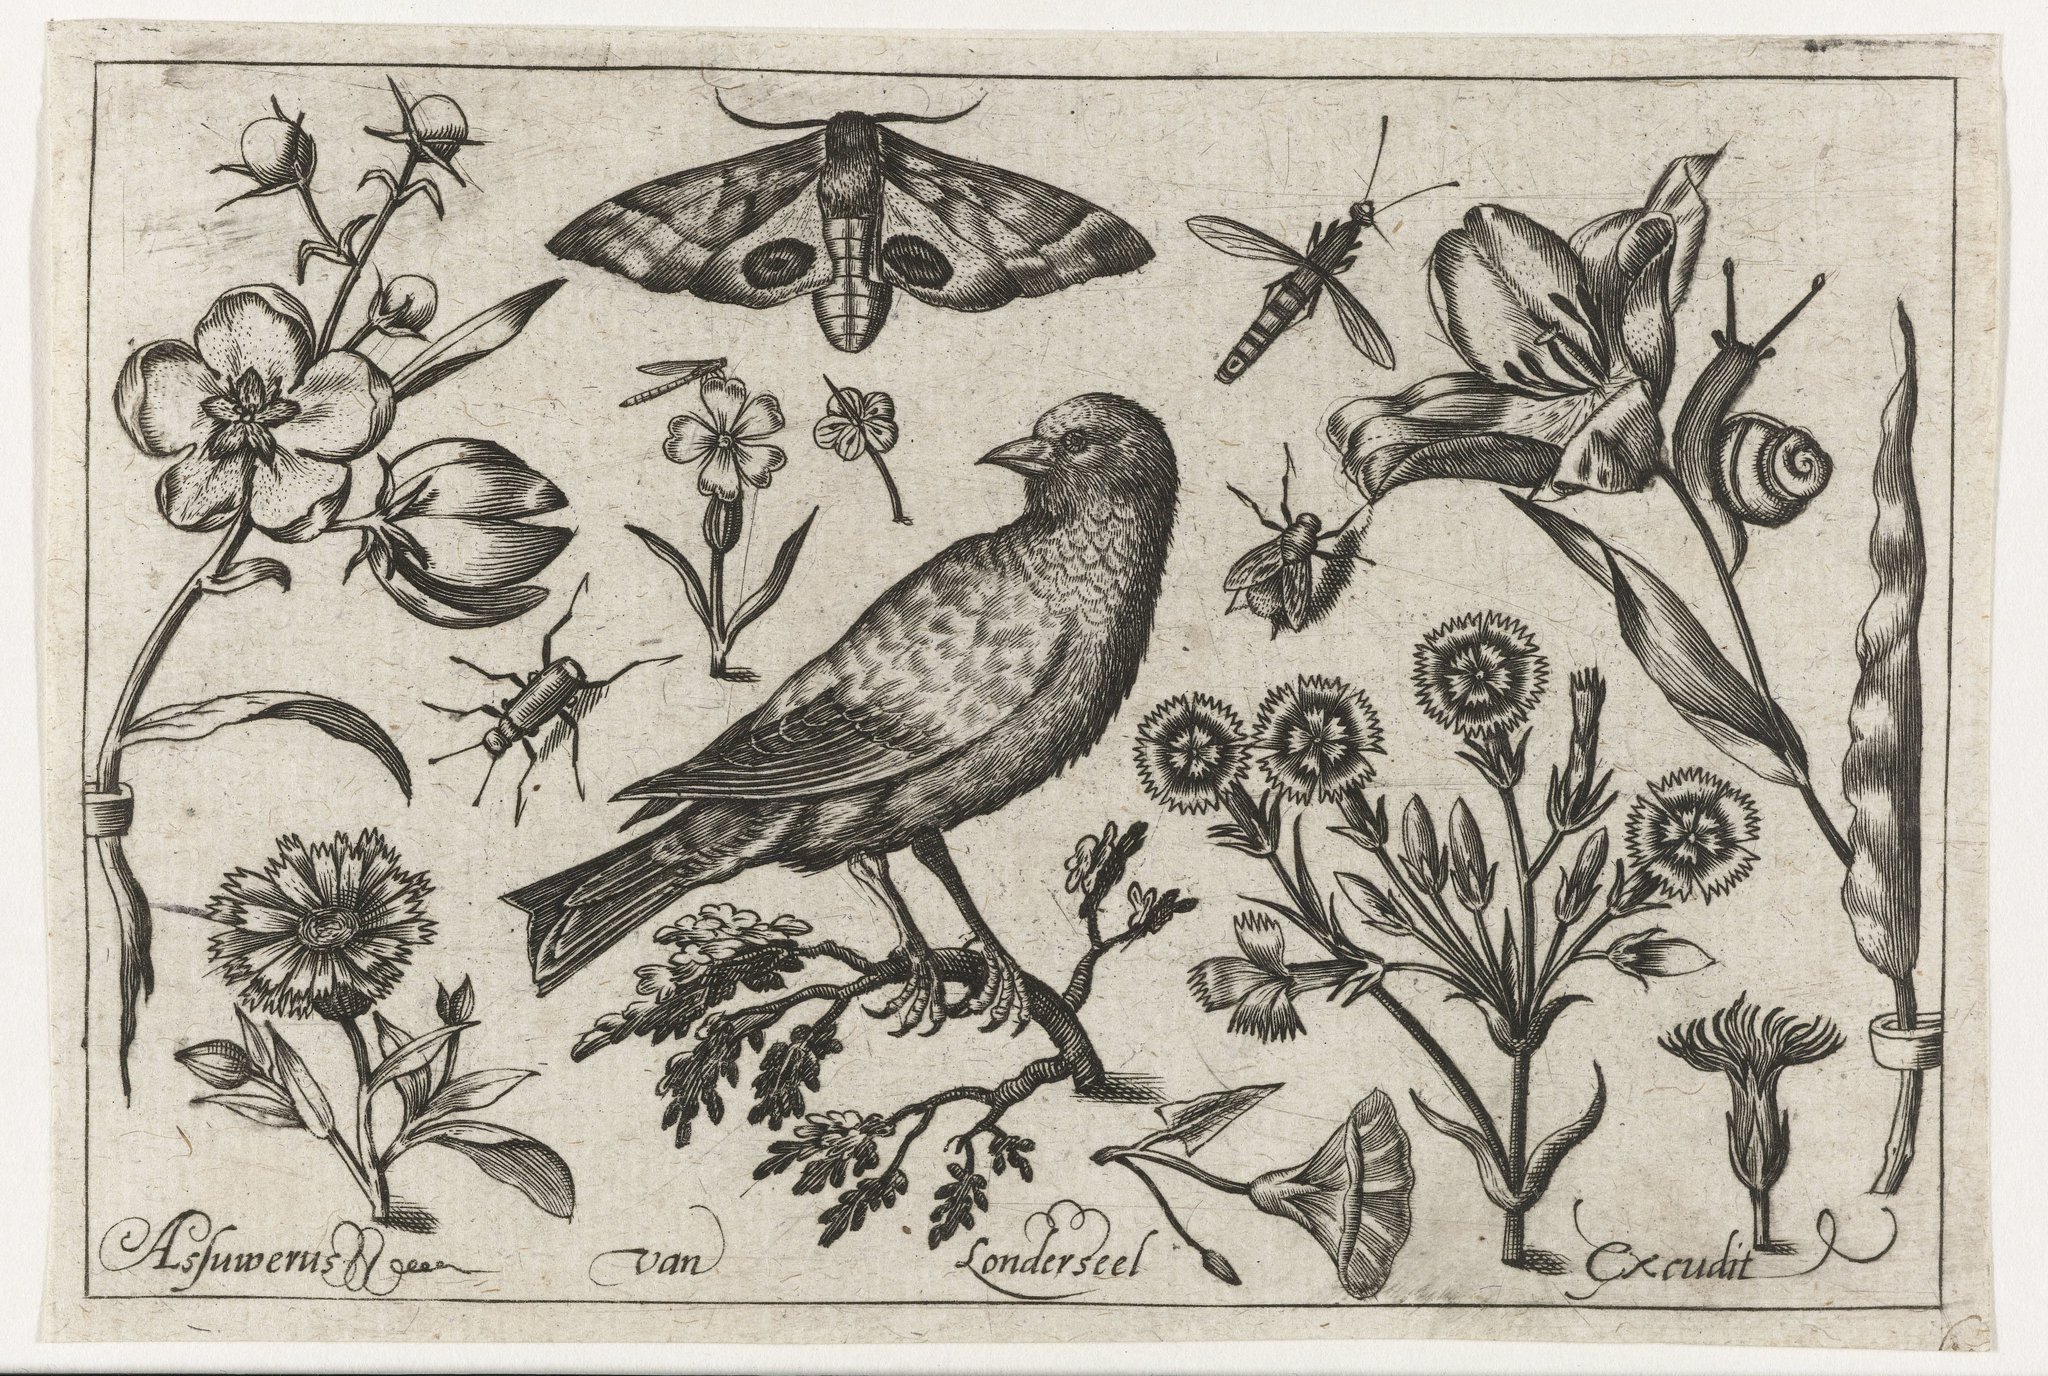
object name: print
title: Vogels, bloemen, insecten etc.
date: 1594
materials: paper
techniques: engraving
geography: netherlands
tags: flowers, song-birds: crow, insects: butterfly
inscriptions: collector's mark: Lugt 2228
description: Bloemen waaronder lelie, insecten en een vlinder, waarschijnlijk een nachtpauwoog en een grote vogel die het meest lijkt op een kraai.